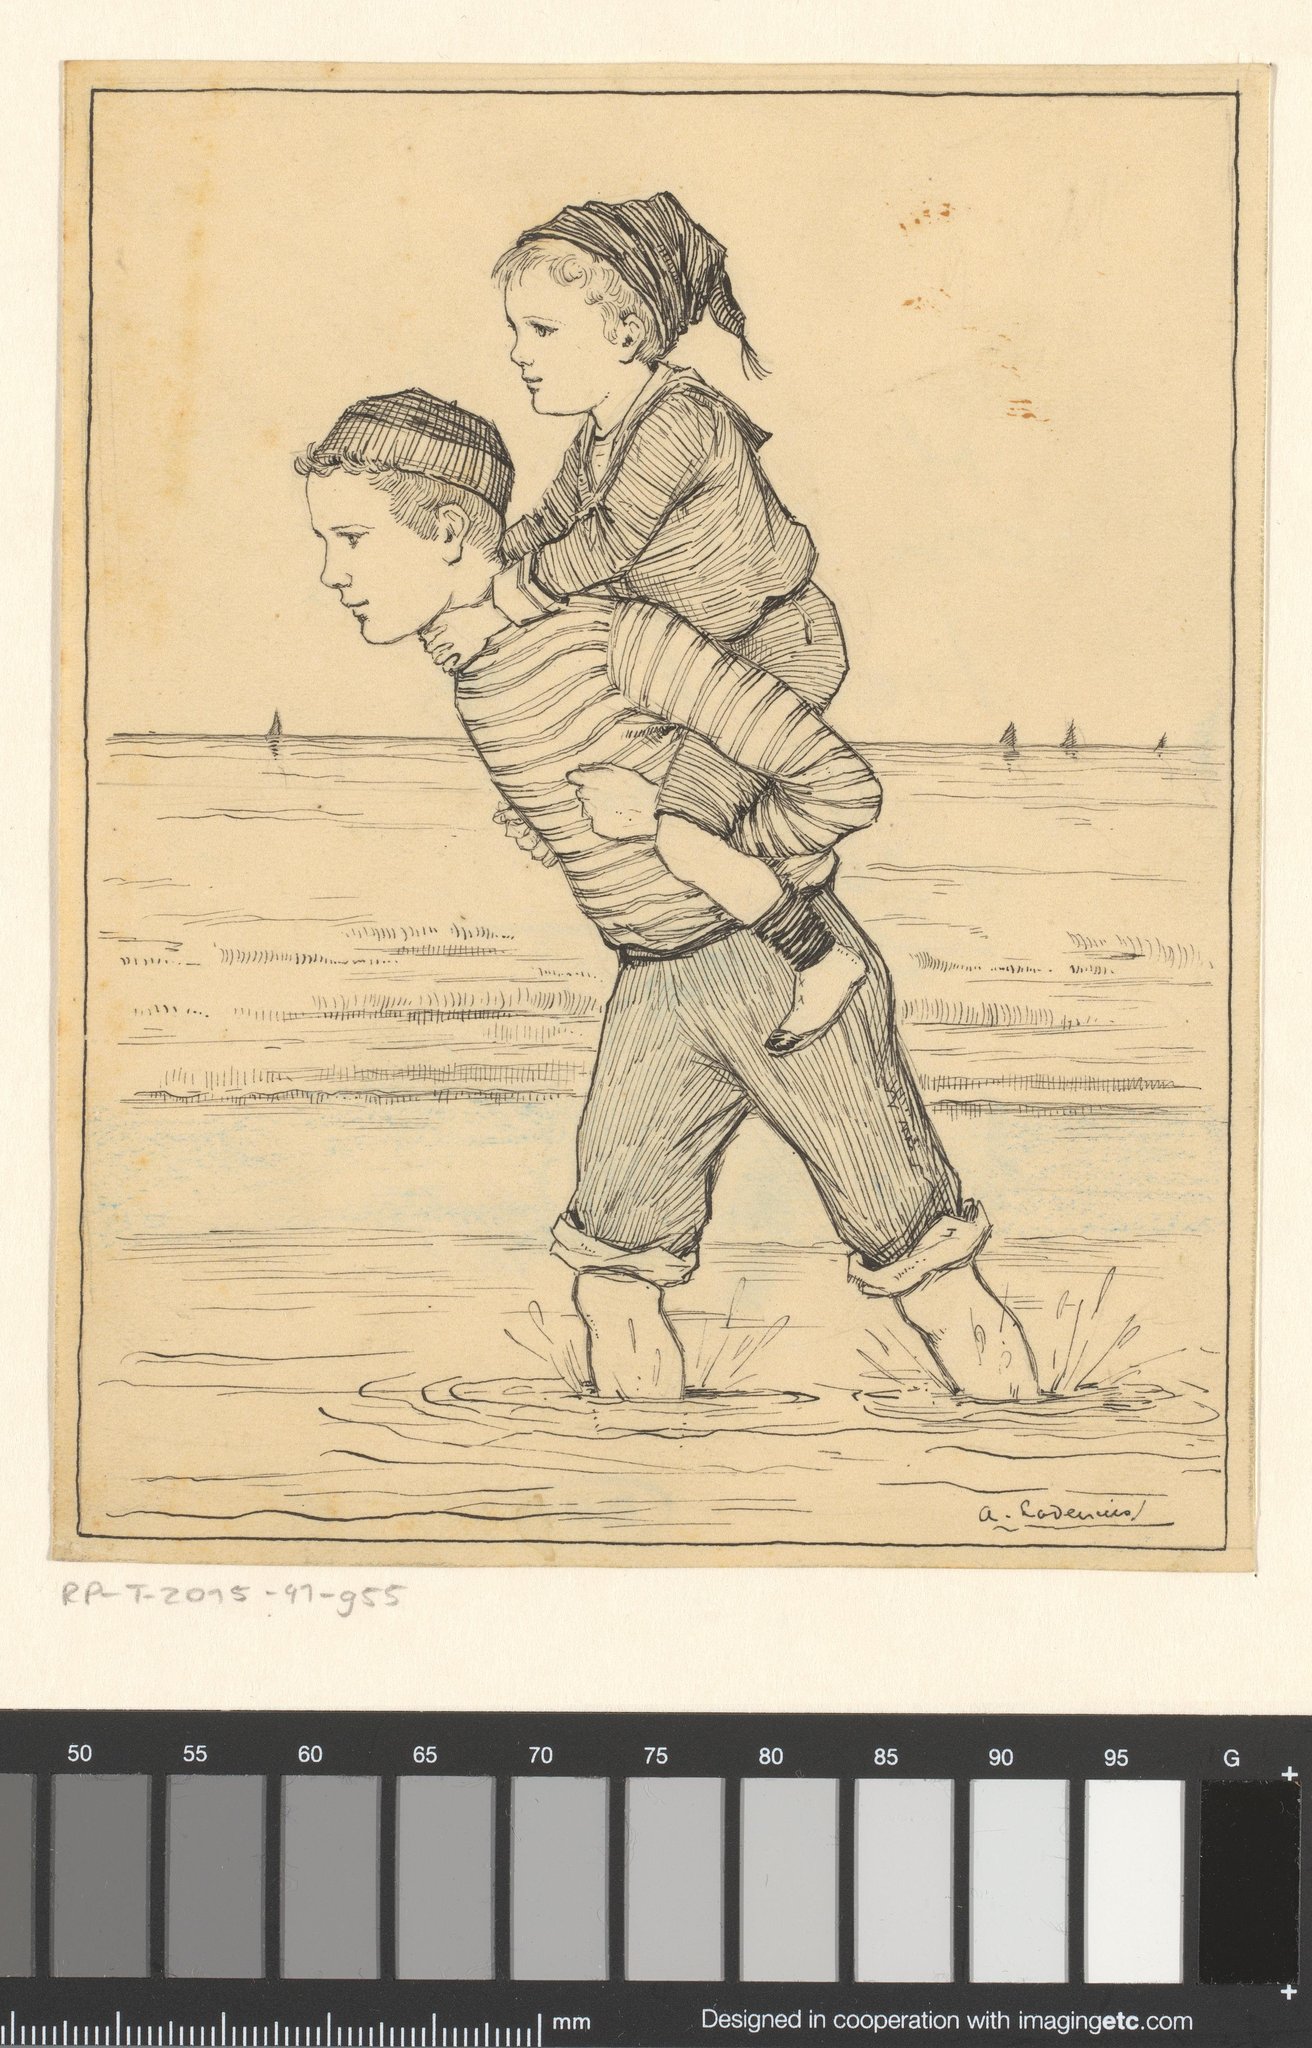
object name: boekillustratie ontwerp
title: Jongen met kind op de rug lopend door zee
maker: adri ladenius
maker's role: draughtsman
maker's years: 1883-1953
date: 1893-1953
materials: ink, paper, pencil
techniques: pen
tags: walking, carrying a child on the back, sea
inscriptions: signature: ‘A. Ladenius’, collector's mark: Lugt 2228, annotation: ‘In zee - s/ toch droog/ gebleven’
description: Een jongen met opgerolde broekspijpen loopt door zee. Hij draagt een jongen op de rug, die zijn armen om de nek van de oudere jongen houdt.